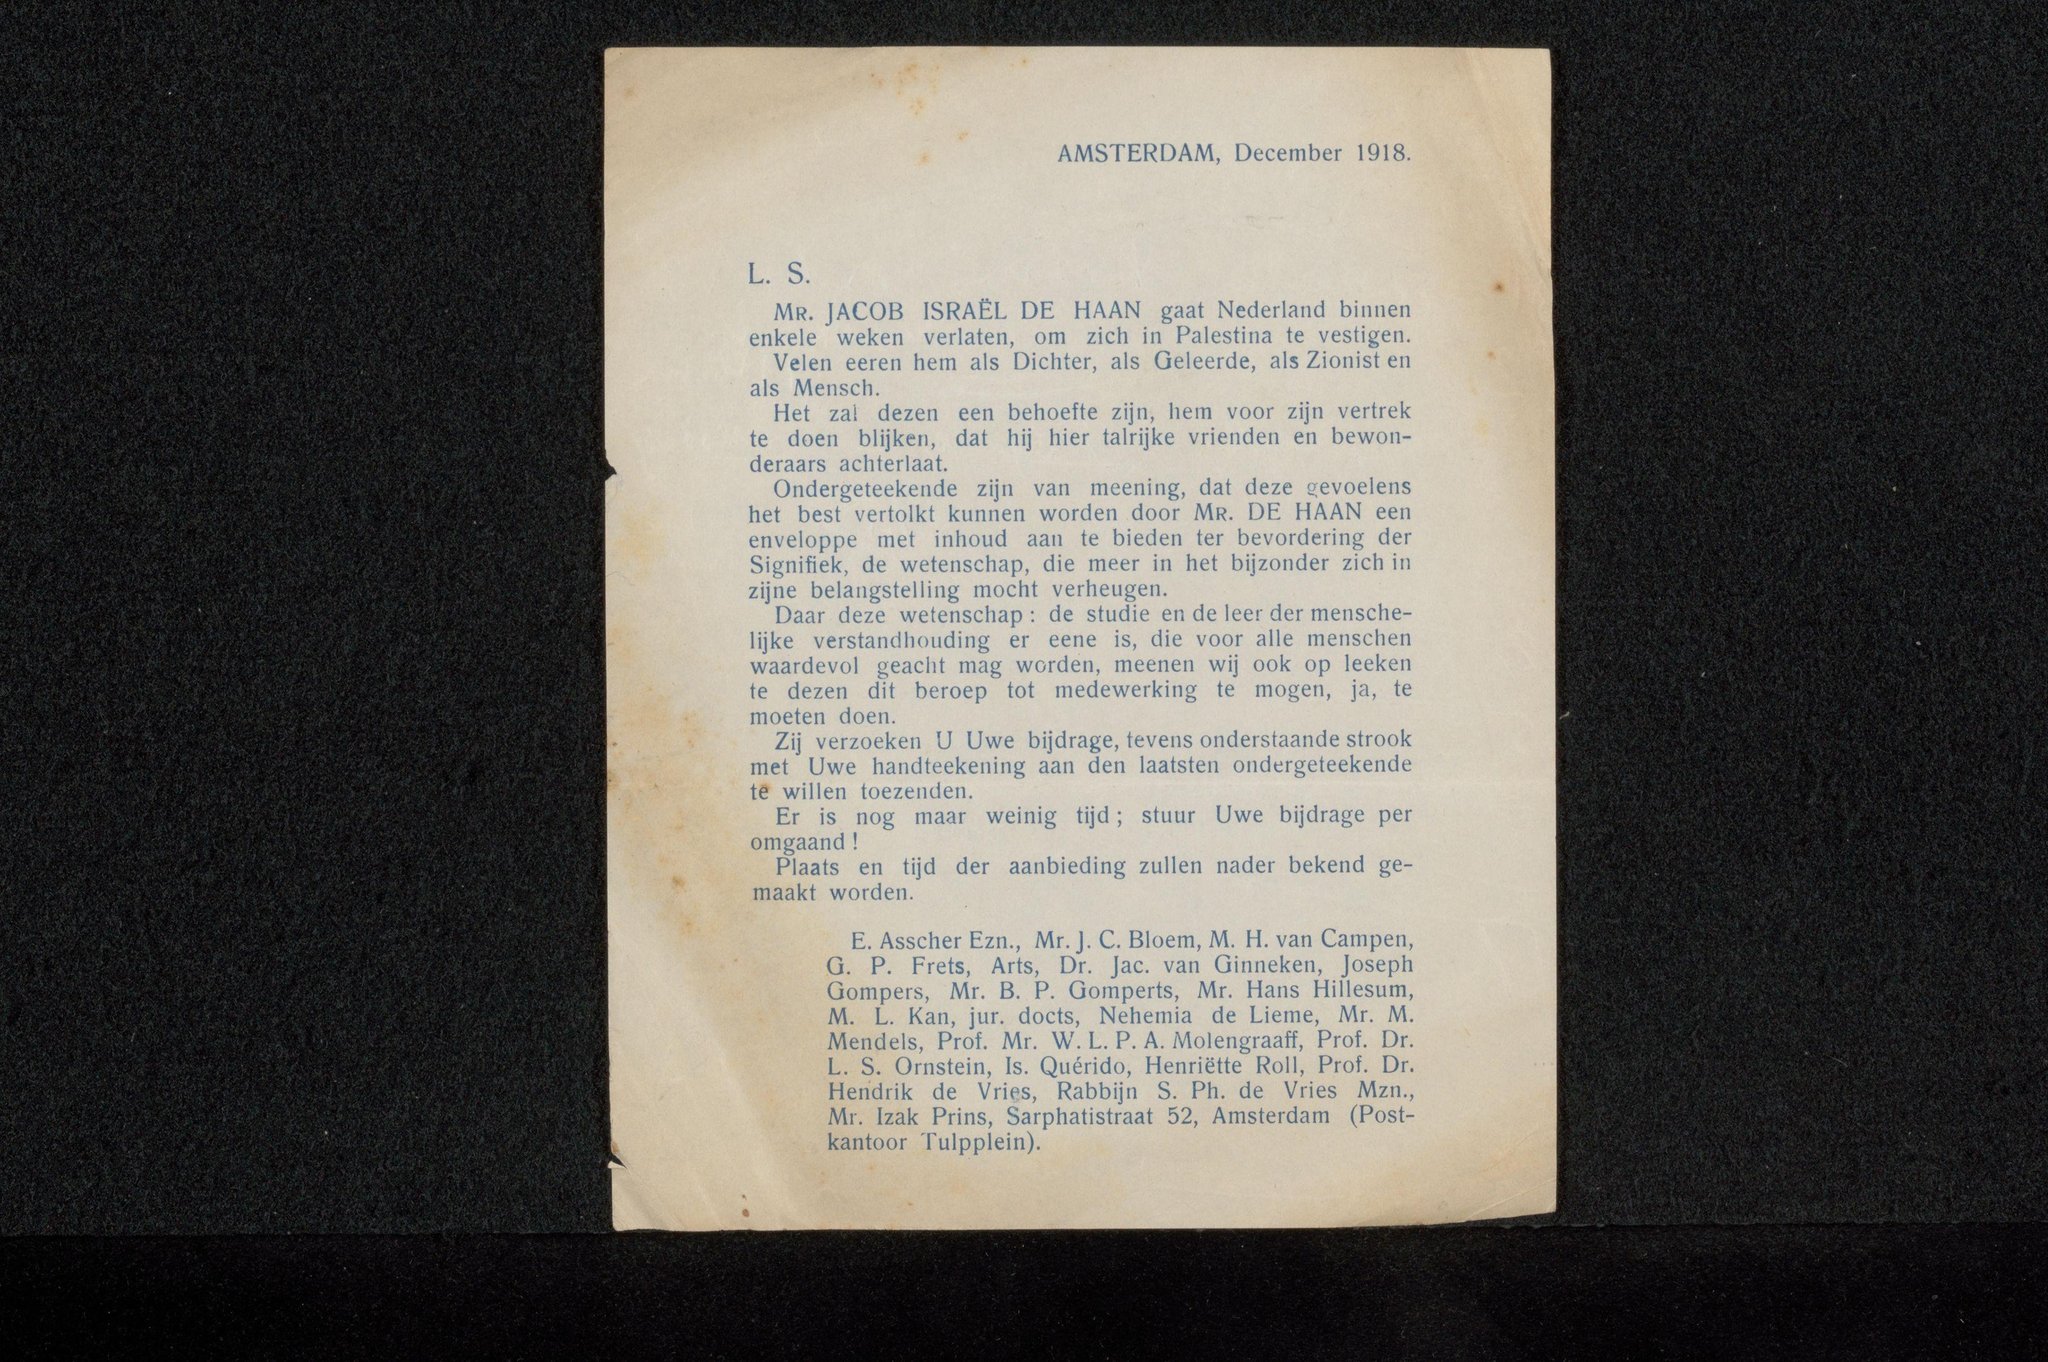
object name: letter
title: Brief aan Philip Zilcken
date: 1912-1918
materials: paper, pencil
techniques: printing, writing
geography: amsterdam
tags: jacob israël de haan, the hague, painter, philip zilcken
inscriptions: collector's mark: ‘RPK’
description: Brief bevat aantekeningen van Philip Zilcken verso.